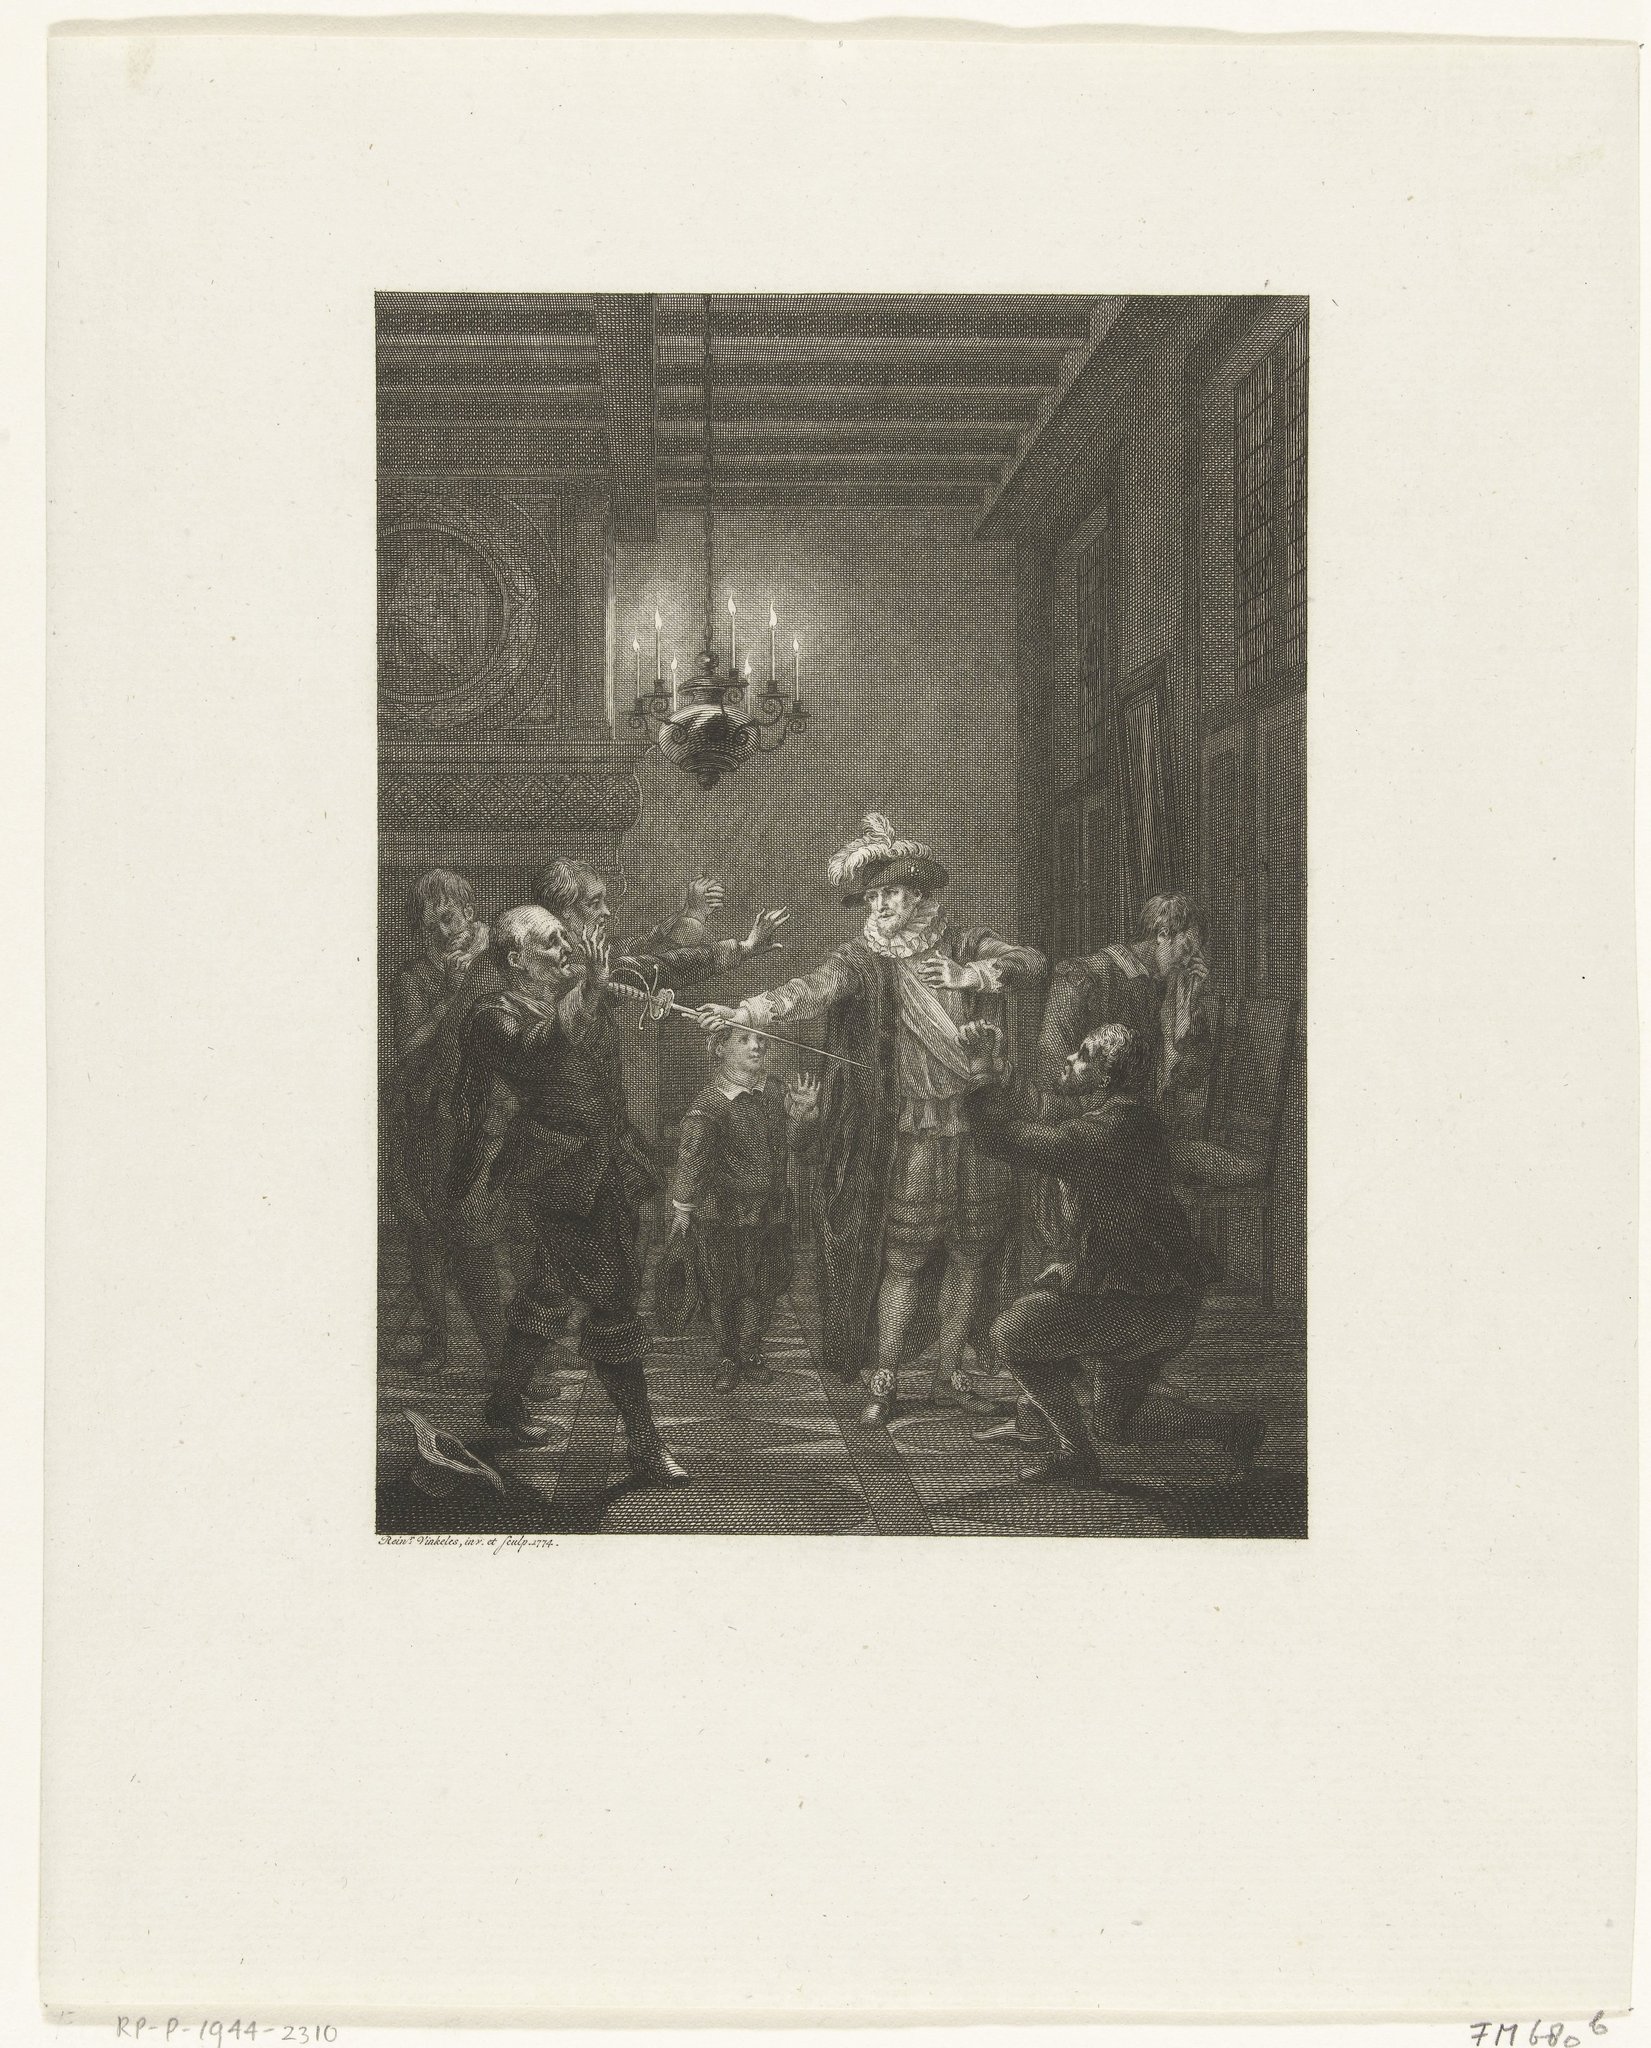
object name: history print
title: De zelfopoffering van burgemeester Pieter van der Werff, 1574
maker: reinier vinkeles (i)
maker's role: draughtsman, print maker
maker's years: 1741-1816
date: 1774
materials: paper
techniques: etching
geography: netherlands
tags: mayor, leiden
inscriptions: date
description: Gebruikt als illustratie in: L.W. van Merken, Het beleg der stad Leyden : Treurspel (IVde Bedr. VIde Toon.), in: N.S. van Winter en L.W. van Merken, Tooneelpoëzy van Nicolaas Simon van Winter, en Lucretia Wilhelmina van Merken, P. Meijer, Amsterdam 1774, 2 delen.